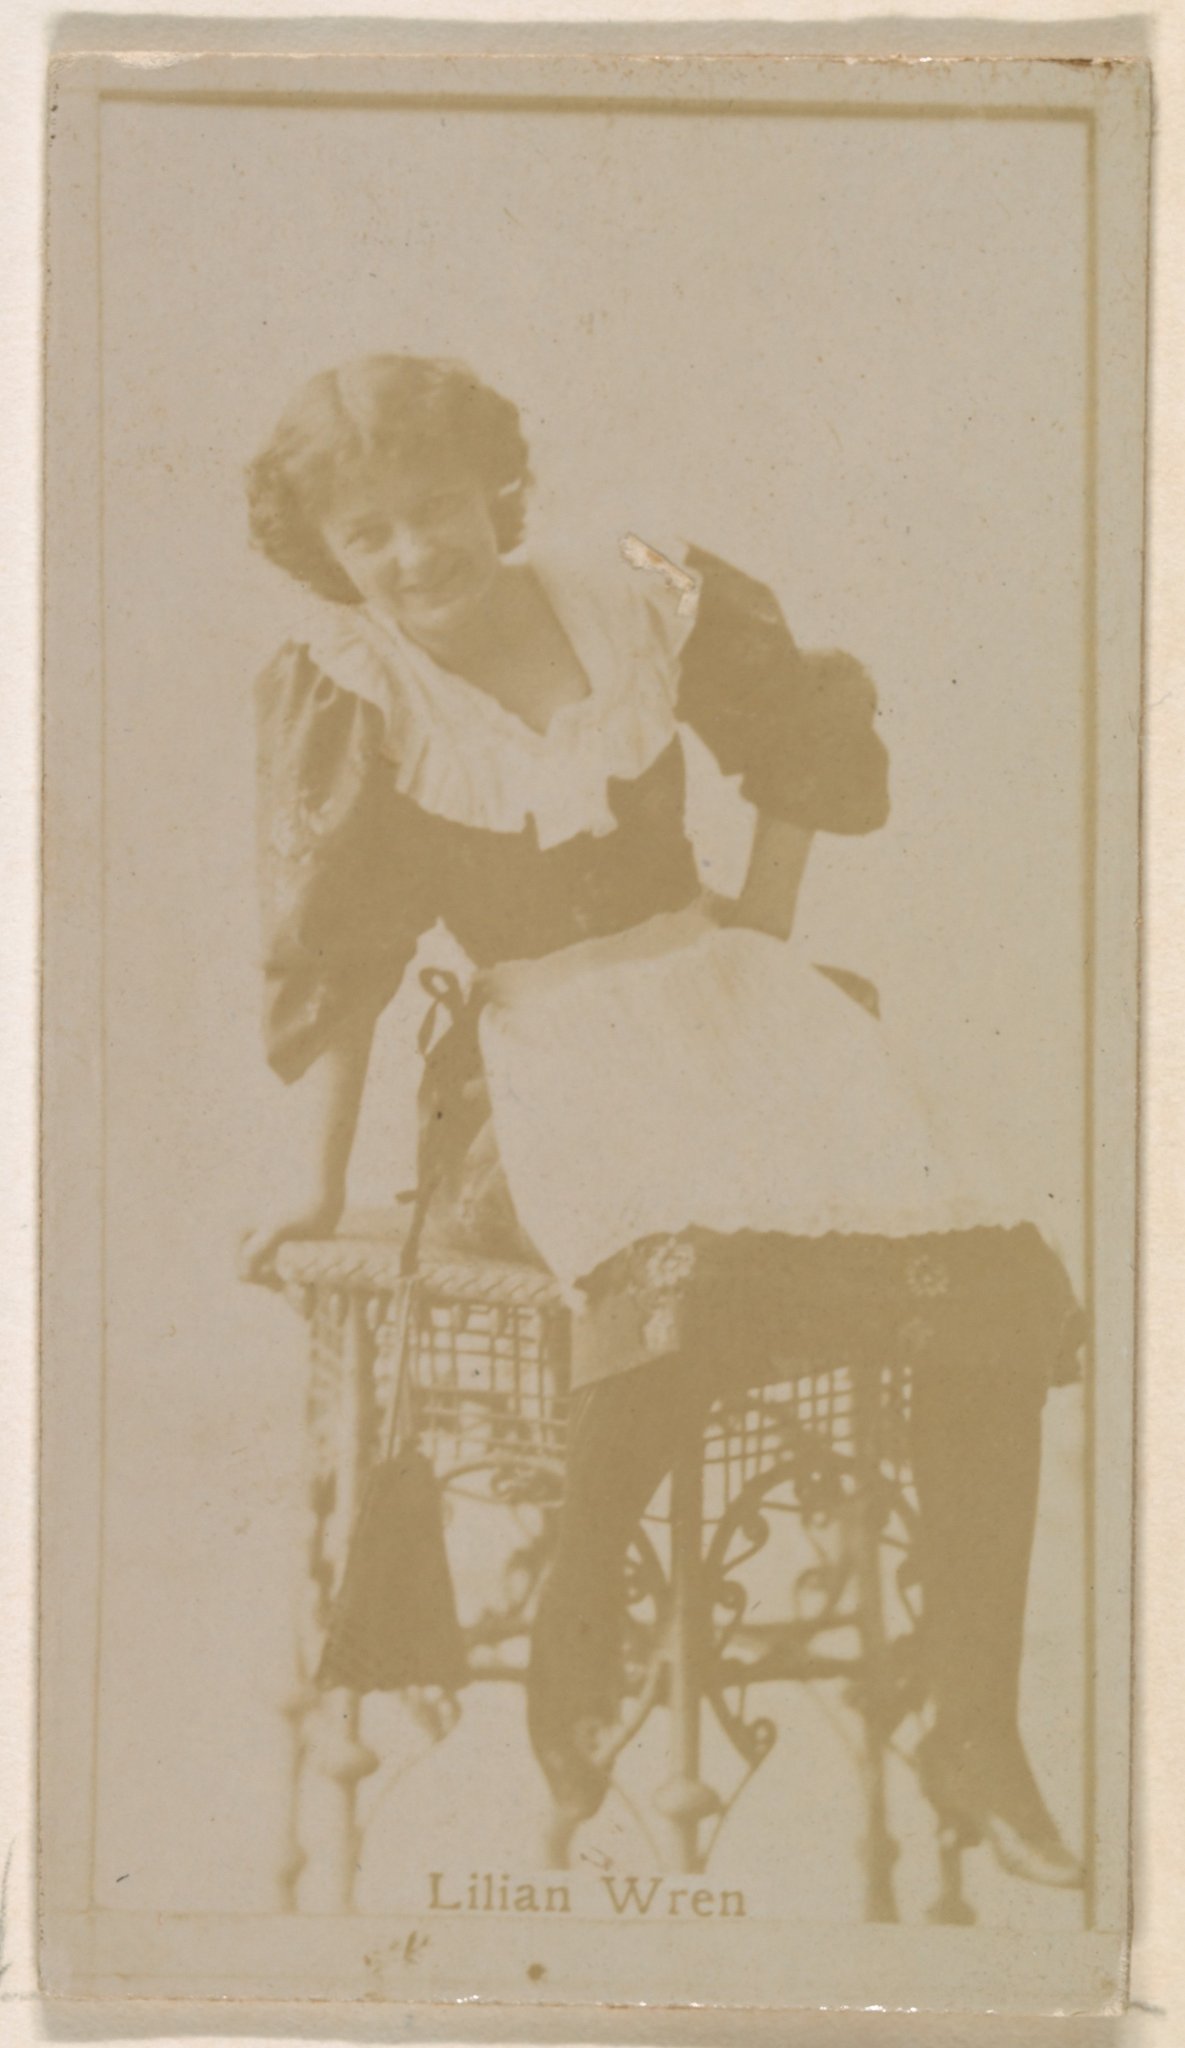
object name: photograph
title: Lilian Wren, from the Actresses series (N245) issued by Kinney Brothers to promote Sweet Caporal Cigarettes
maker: kinney brothers tobacco company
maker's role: publisher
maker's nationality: american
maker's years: 1869-2011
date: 1890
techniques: albumen silver print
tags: portraits,women,actresses